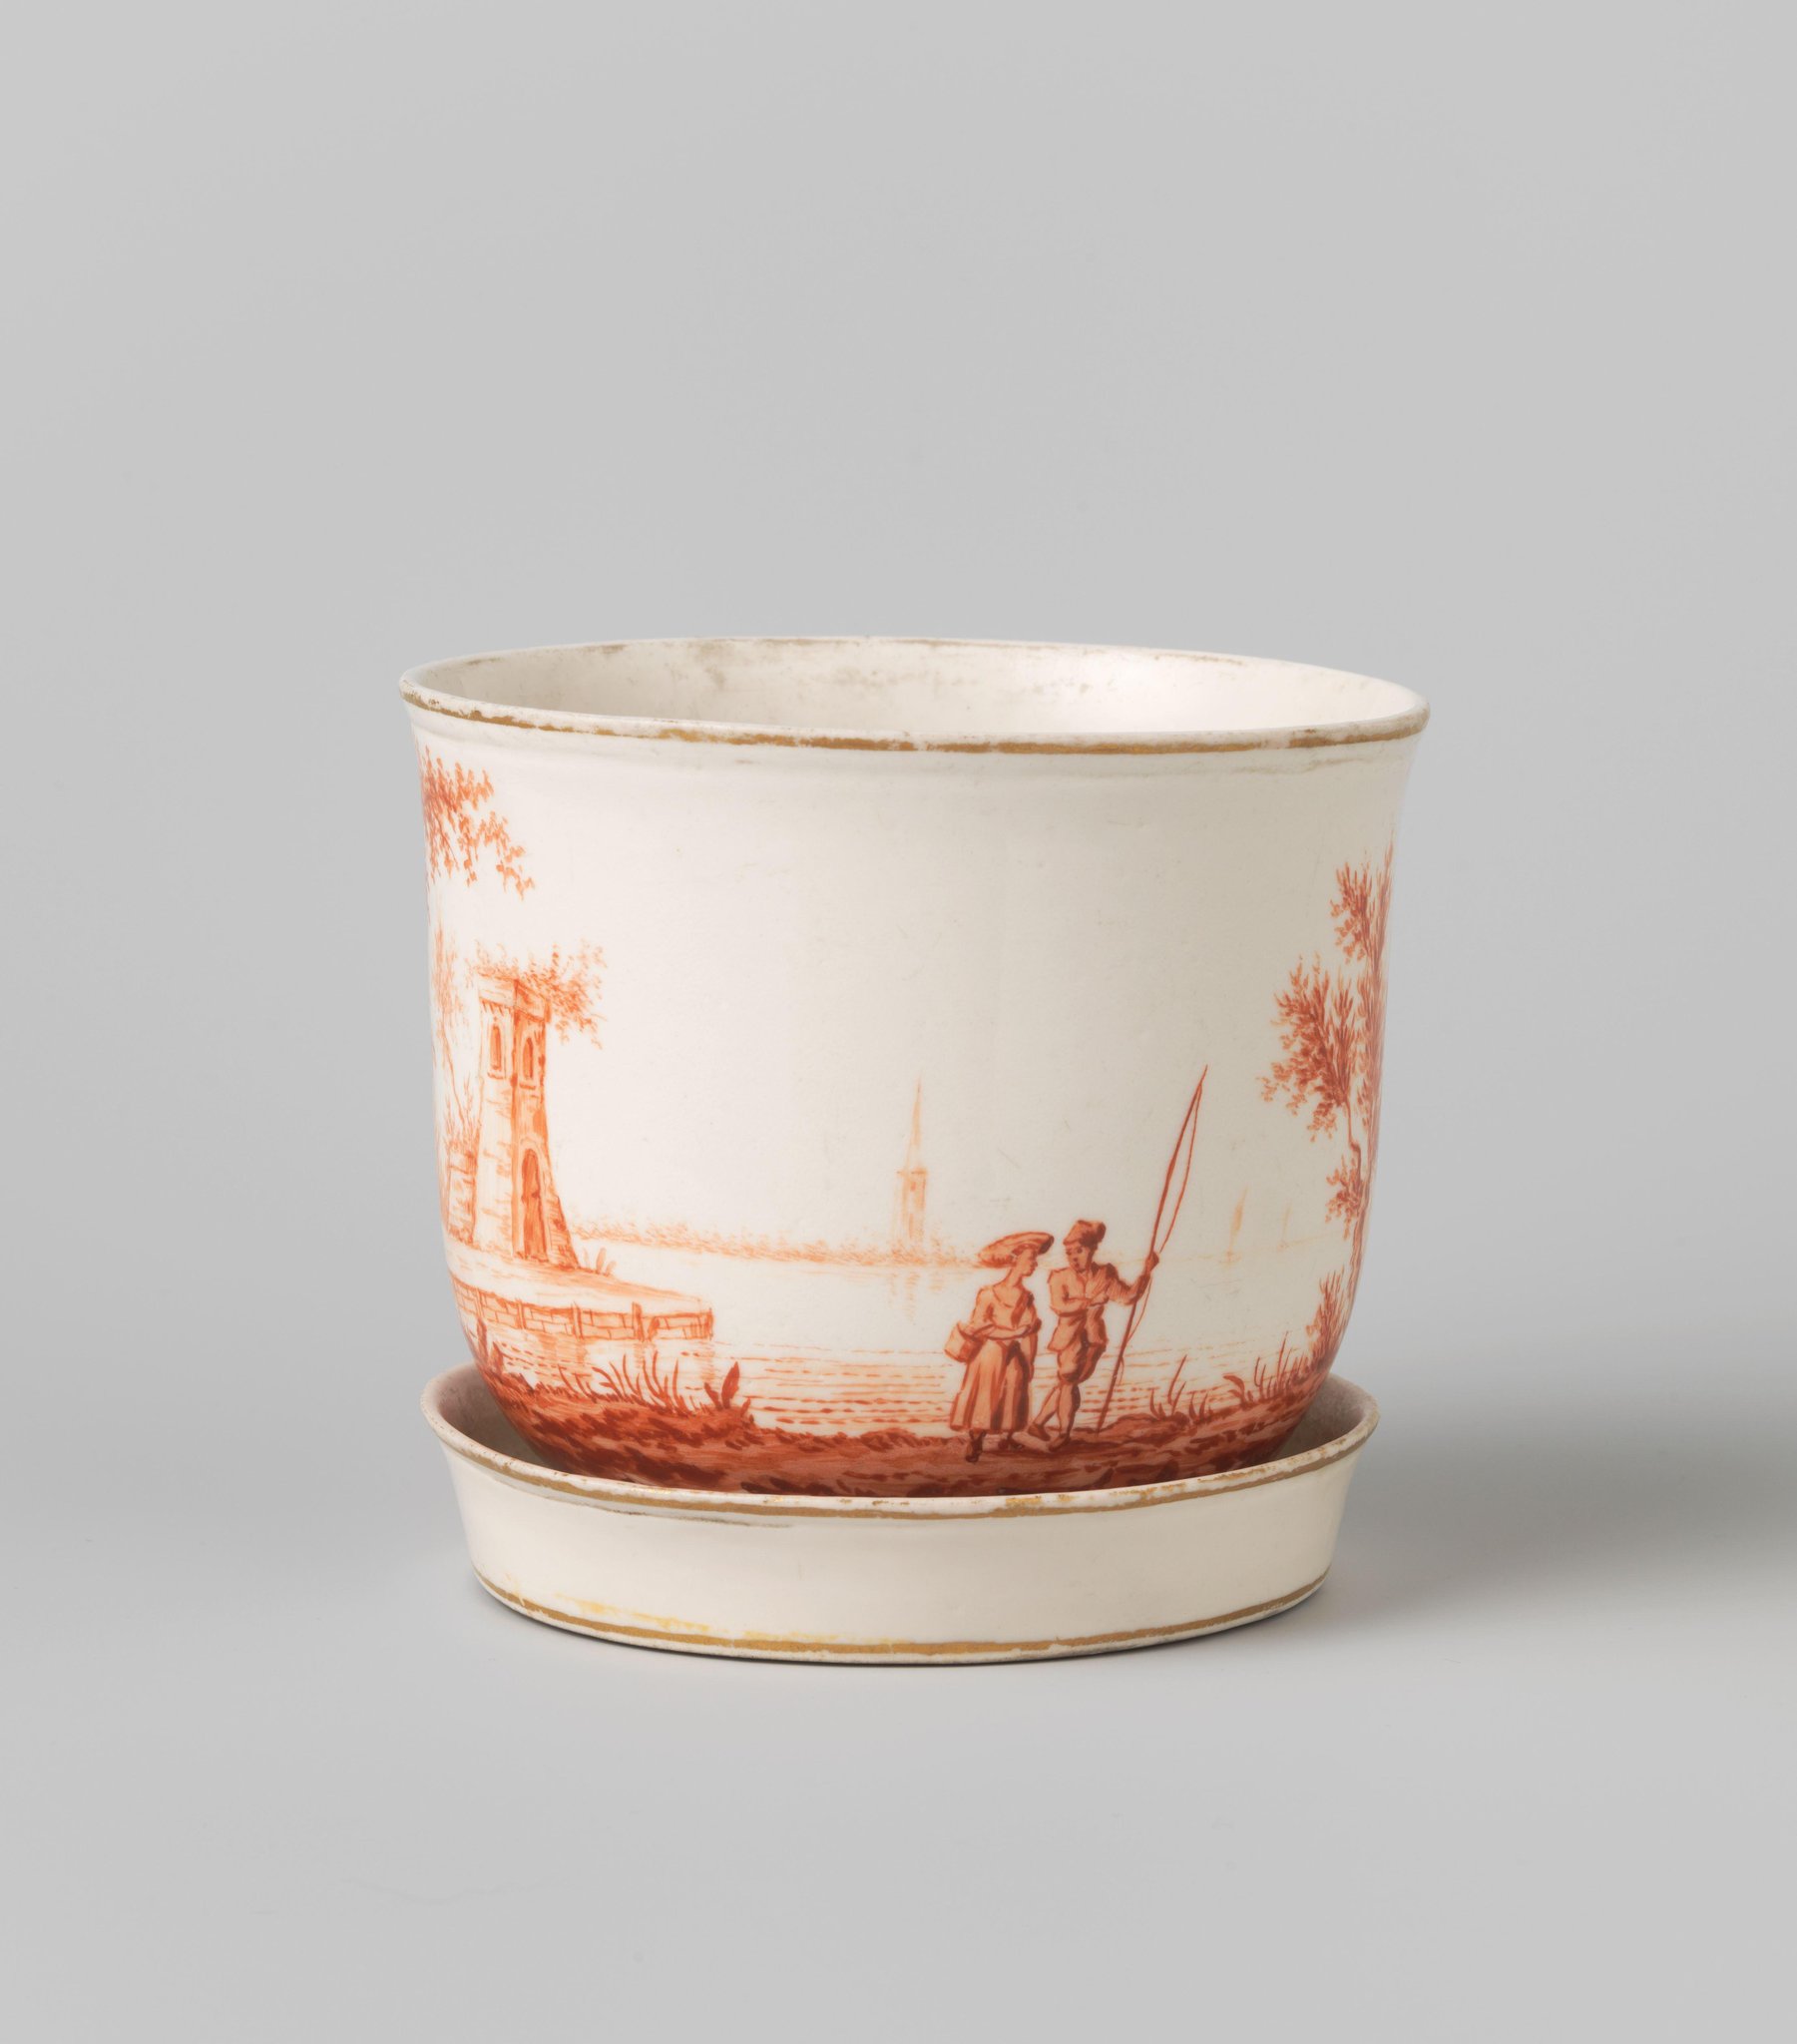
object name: platter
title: Bloempot op onderschotel van porselein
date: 1774-1784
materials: porcelain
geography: loosdrecht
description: Jardinière and stand, c. 1774 - 1778.